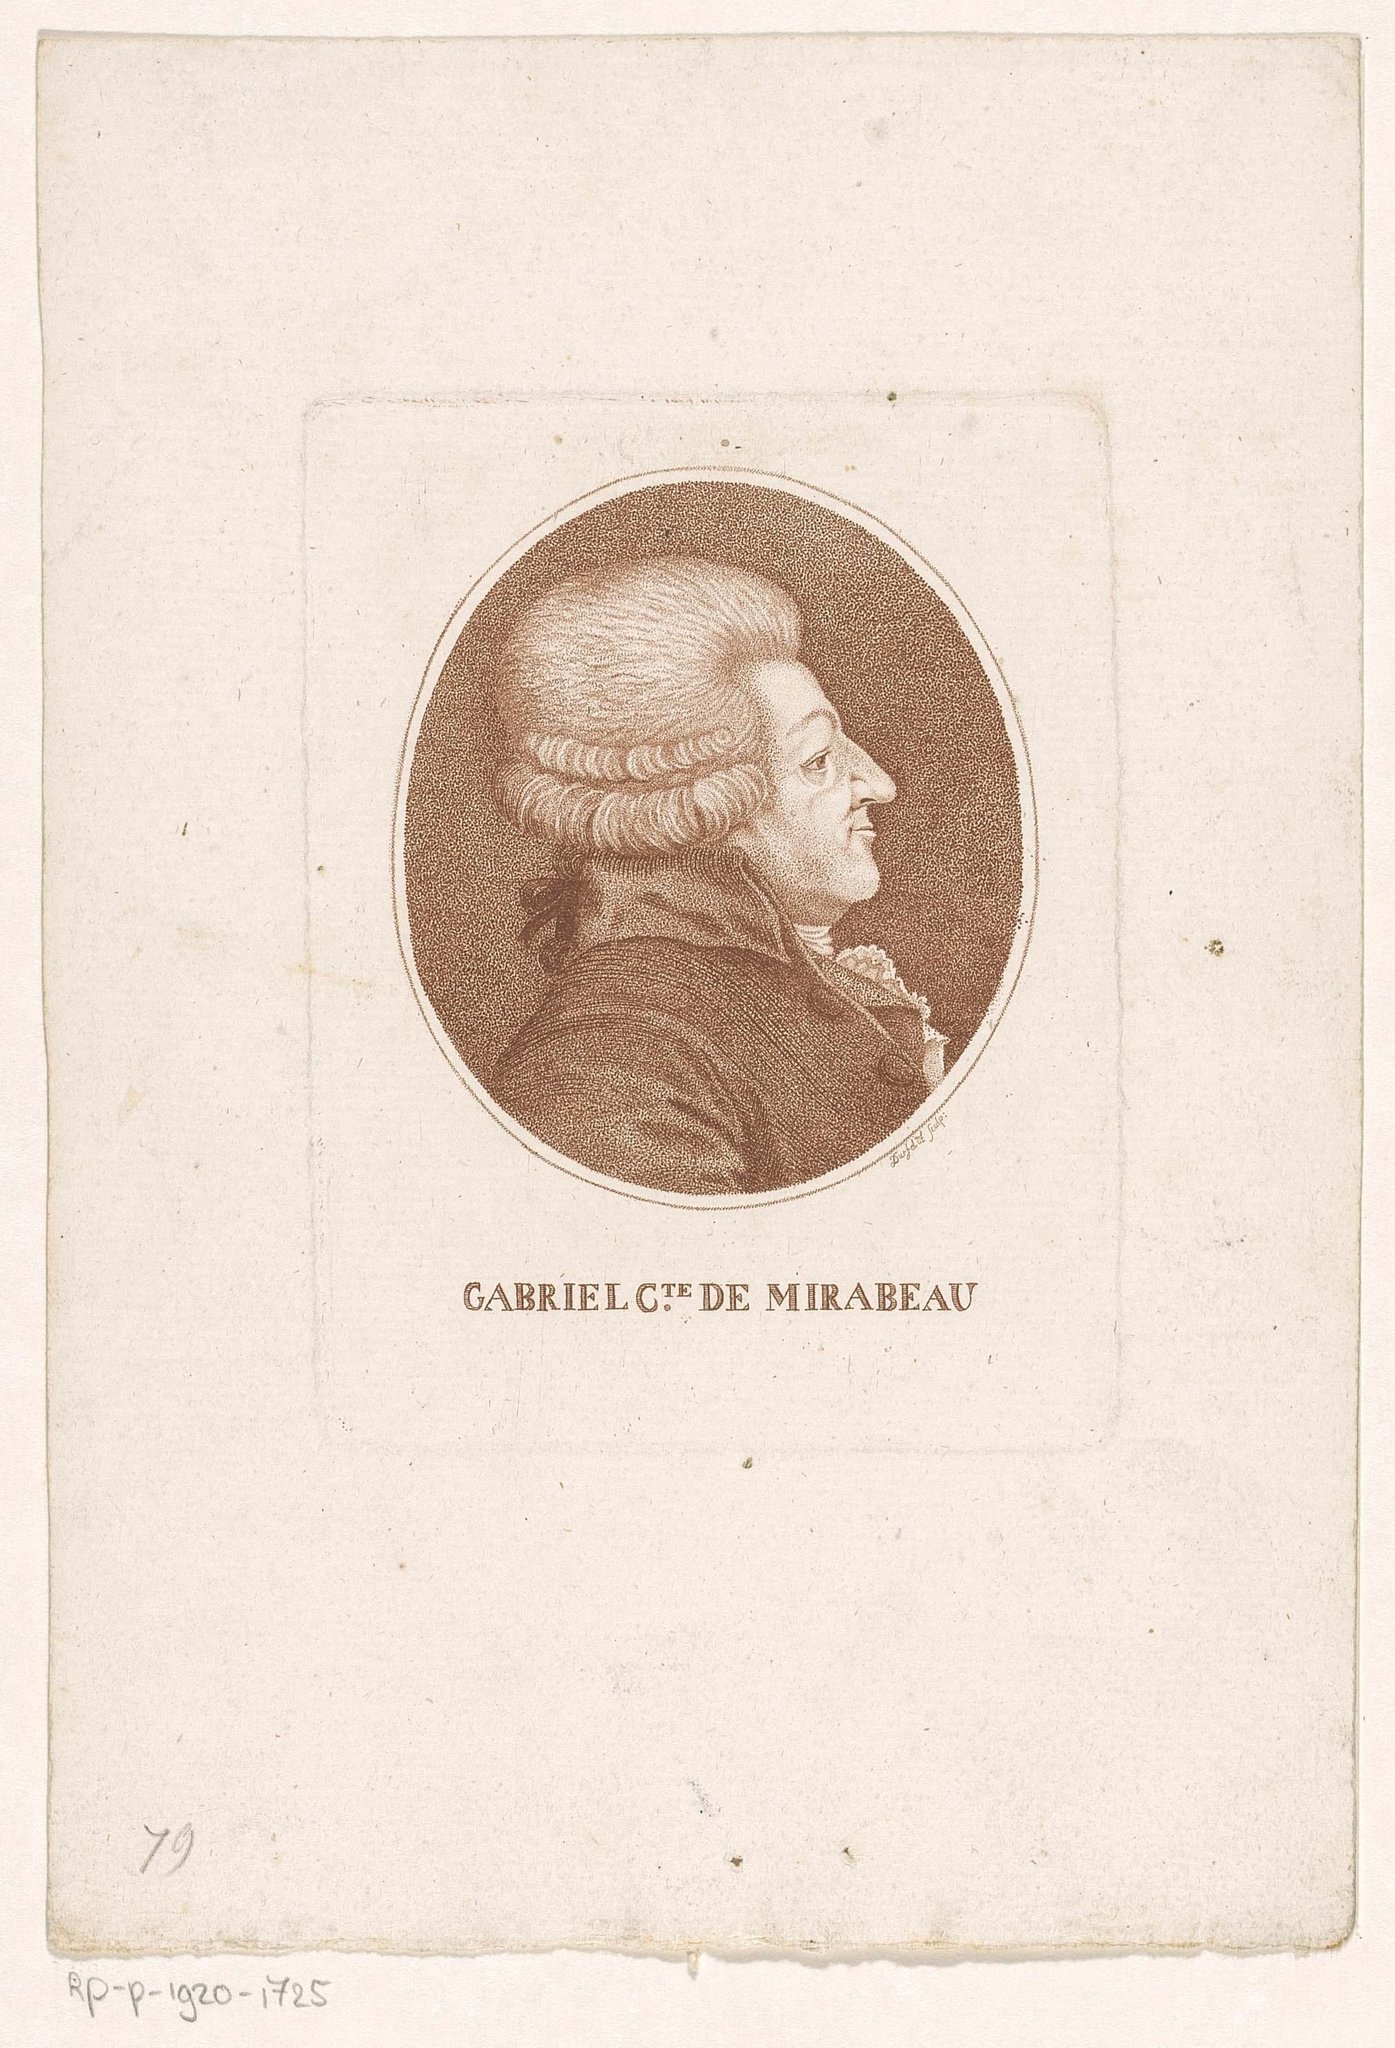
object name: print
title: Portret van Gabriel de Riqueti Marquis de Mirabeau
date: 1775-1827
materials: paper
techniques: stippling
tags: paris, politician, honoré-gabriel de riqueti (graaf van mirabeau), historical persons, wig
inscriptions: collector's mark: Lugt 2228